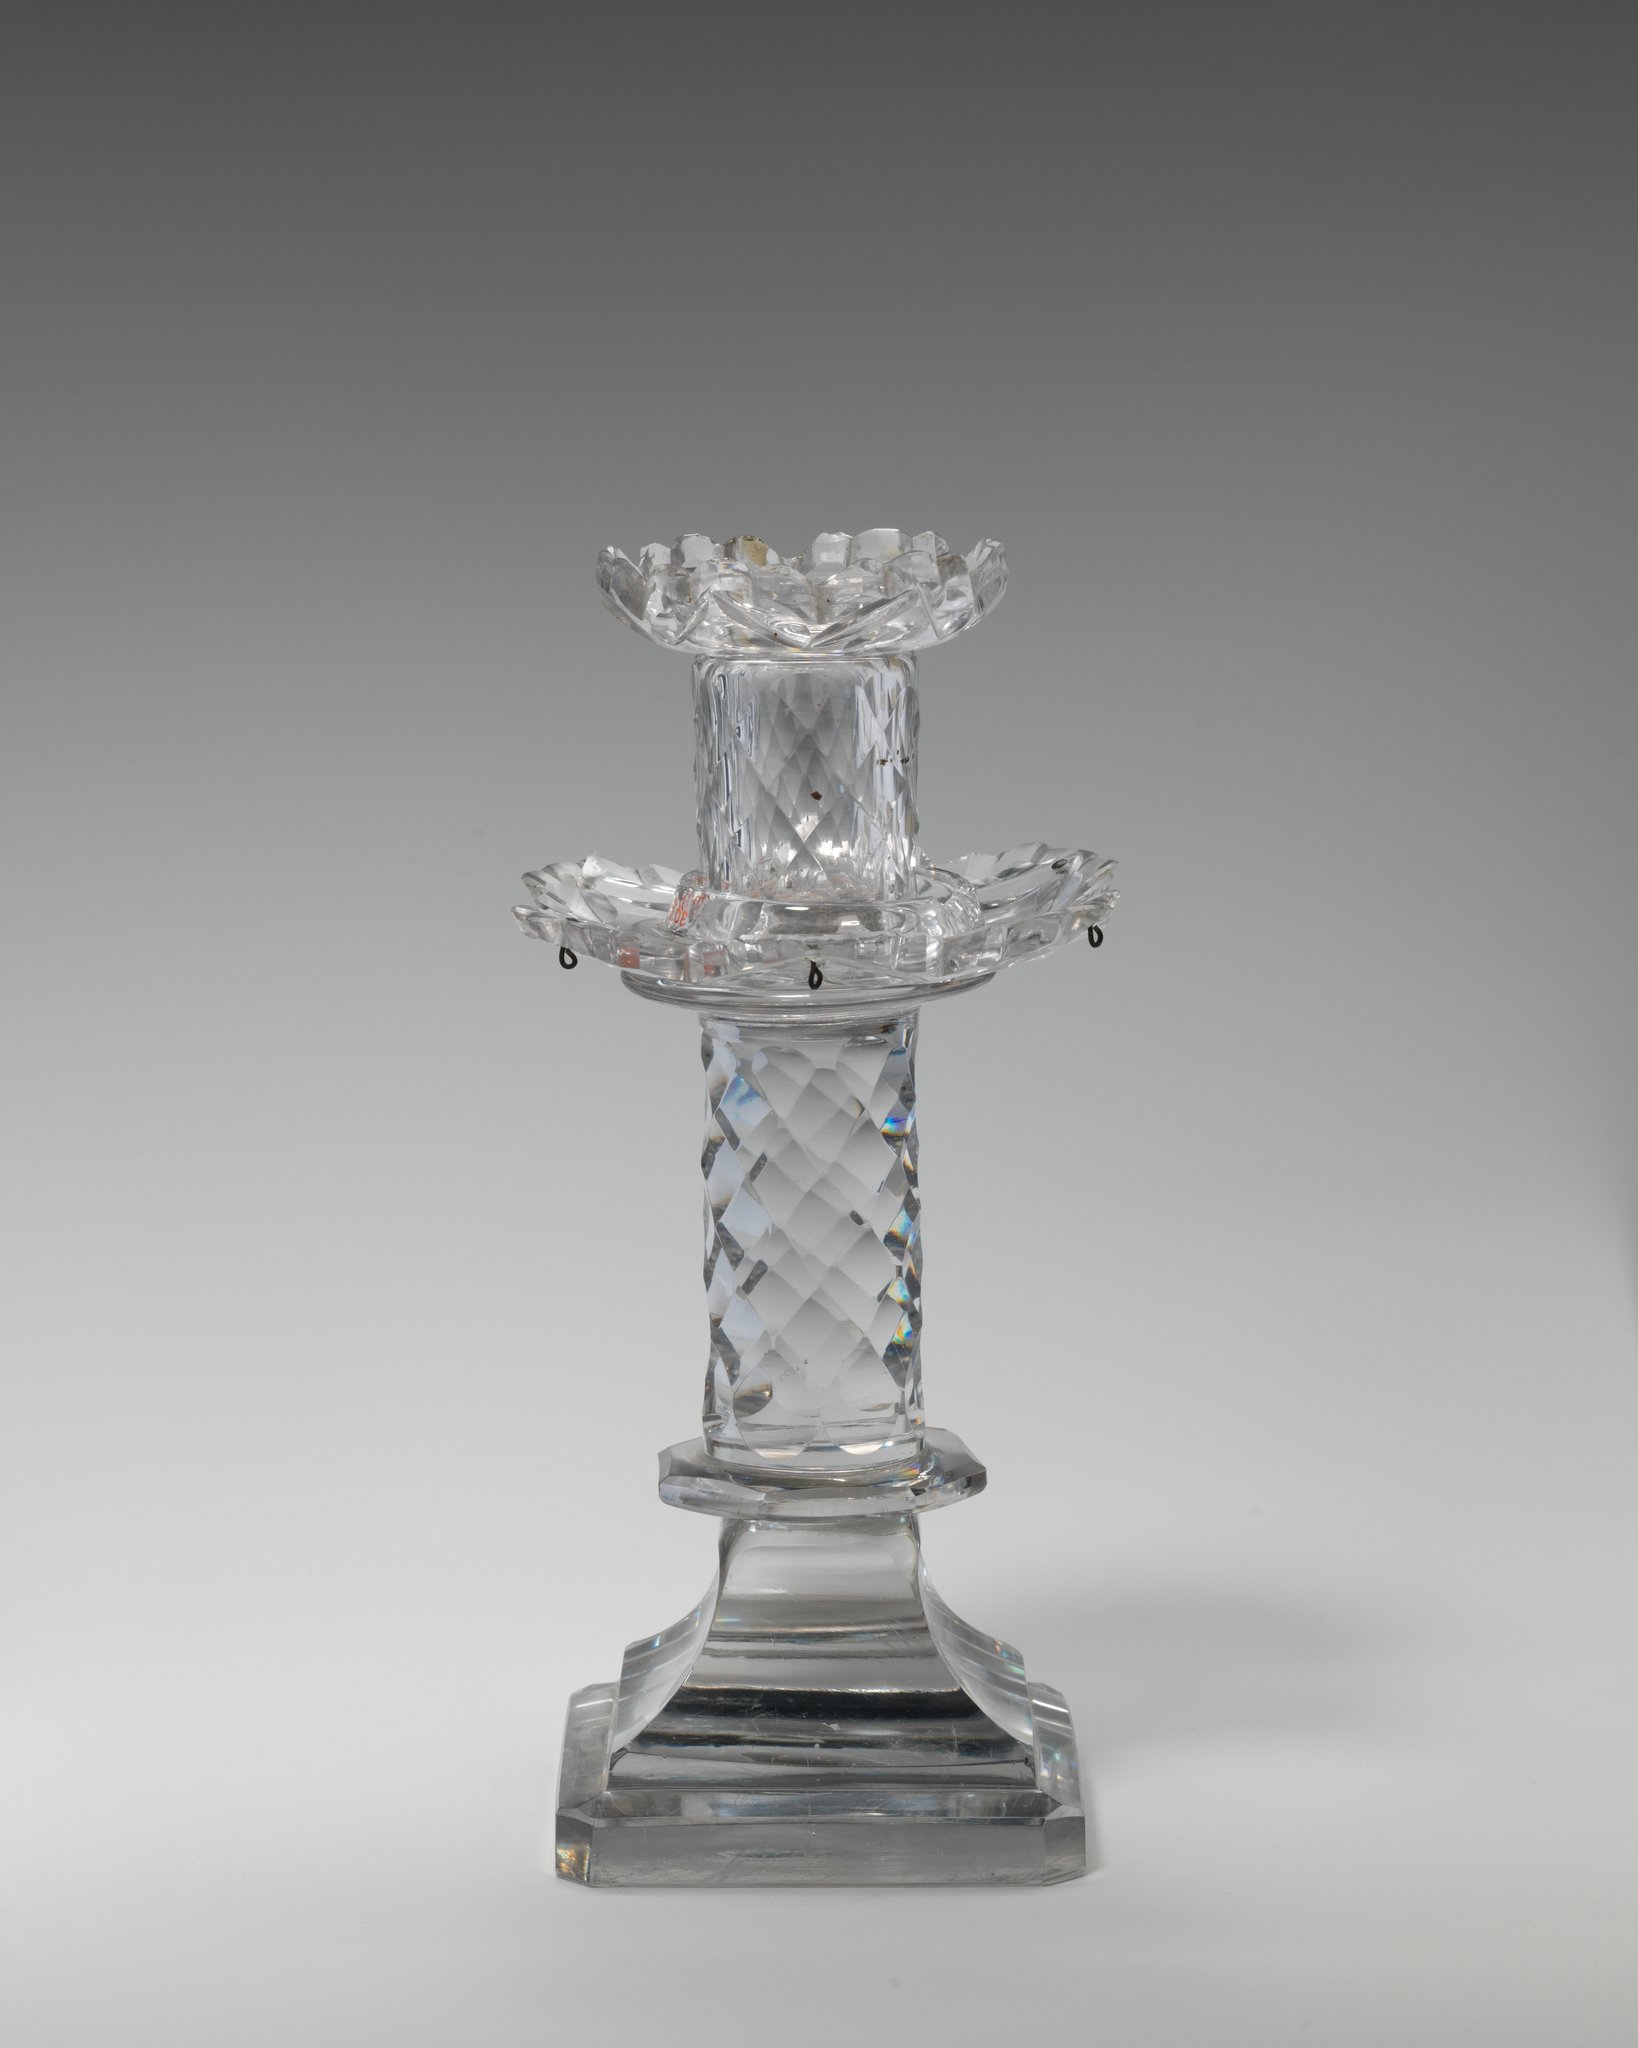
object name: candlestick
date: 1767-1833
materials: glass